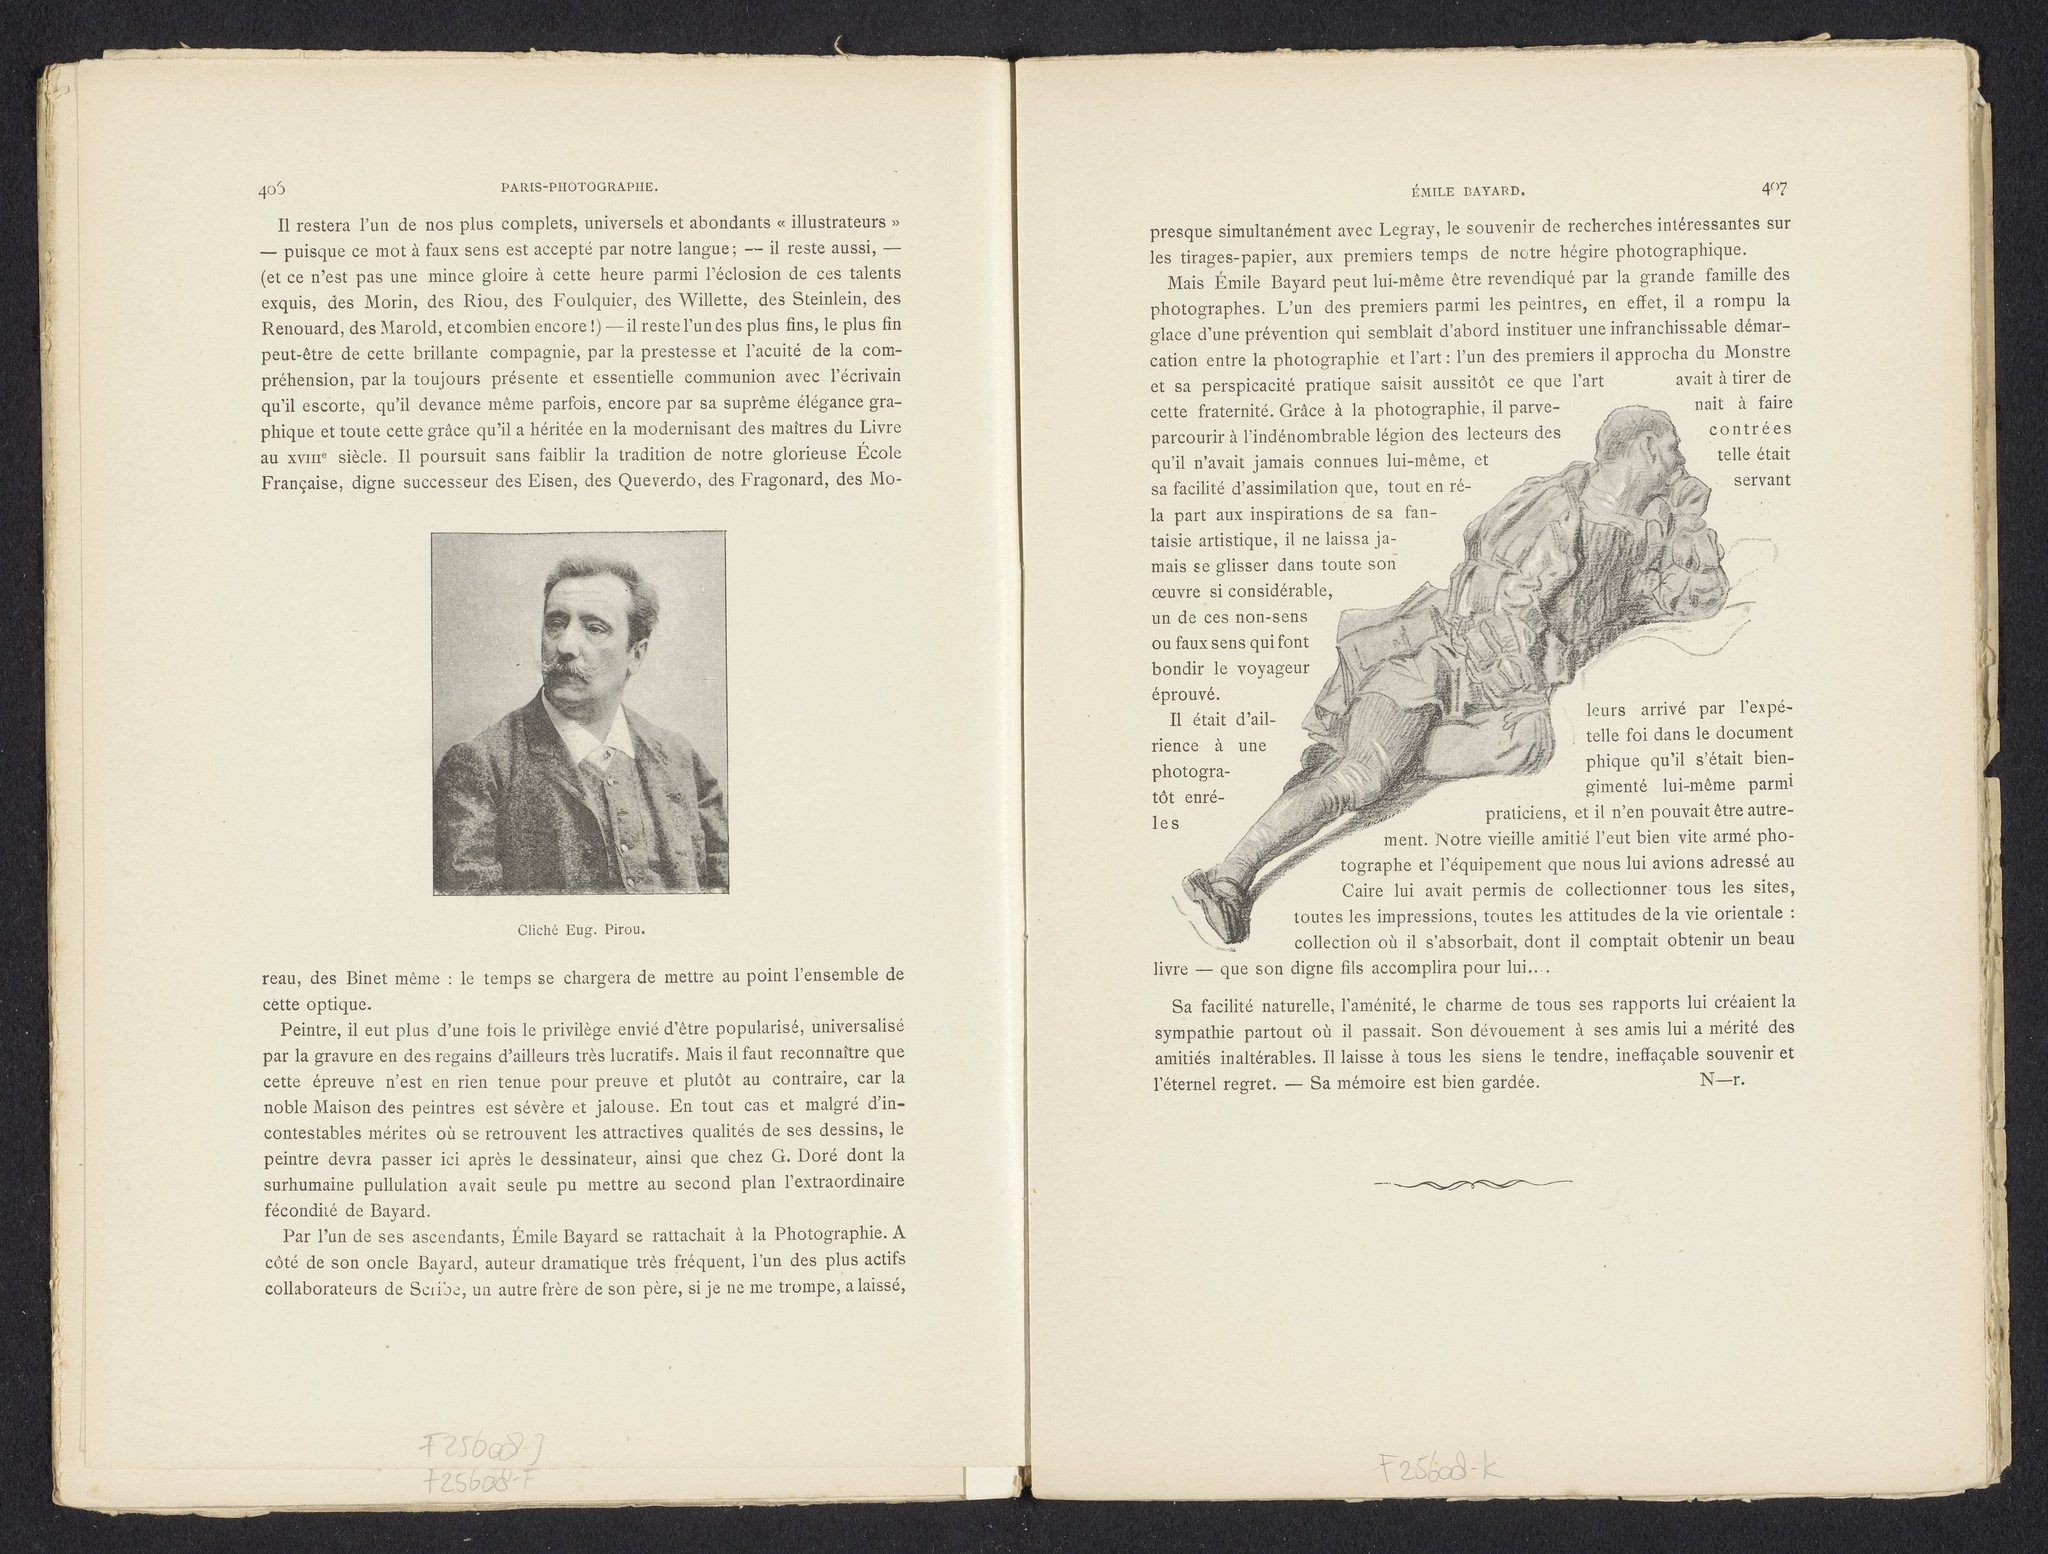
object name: page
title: Portret van Émile Bayard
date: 1881-1891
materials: paper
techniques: autotype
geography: france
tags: painter, draughtsman, émile-antoine bayard, portrait, self-portrait of artist